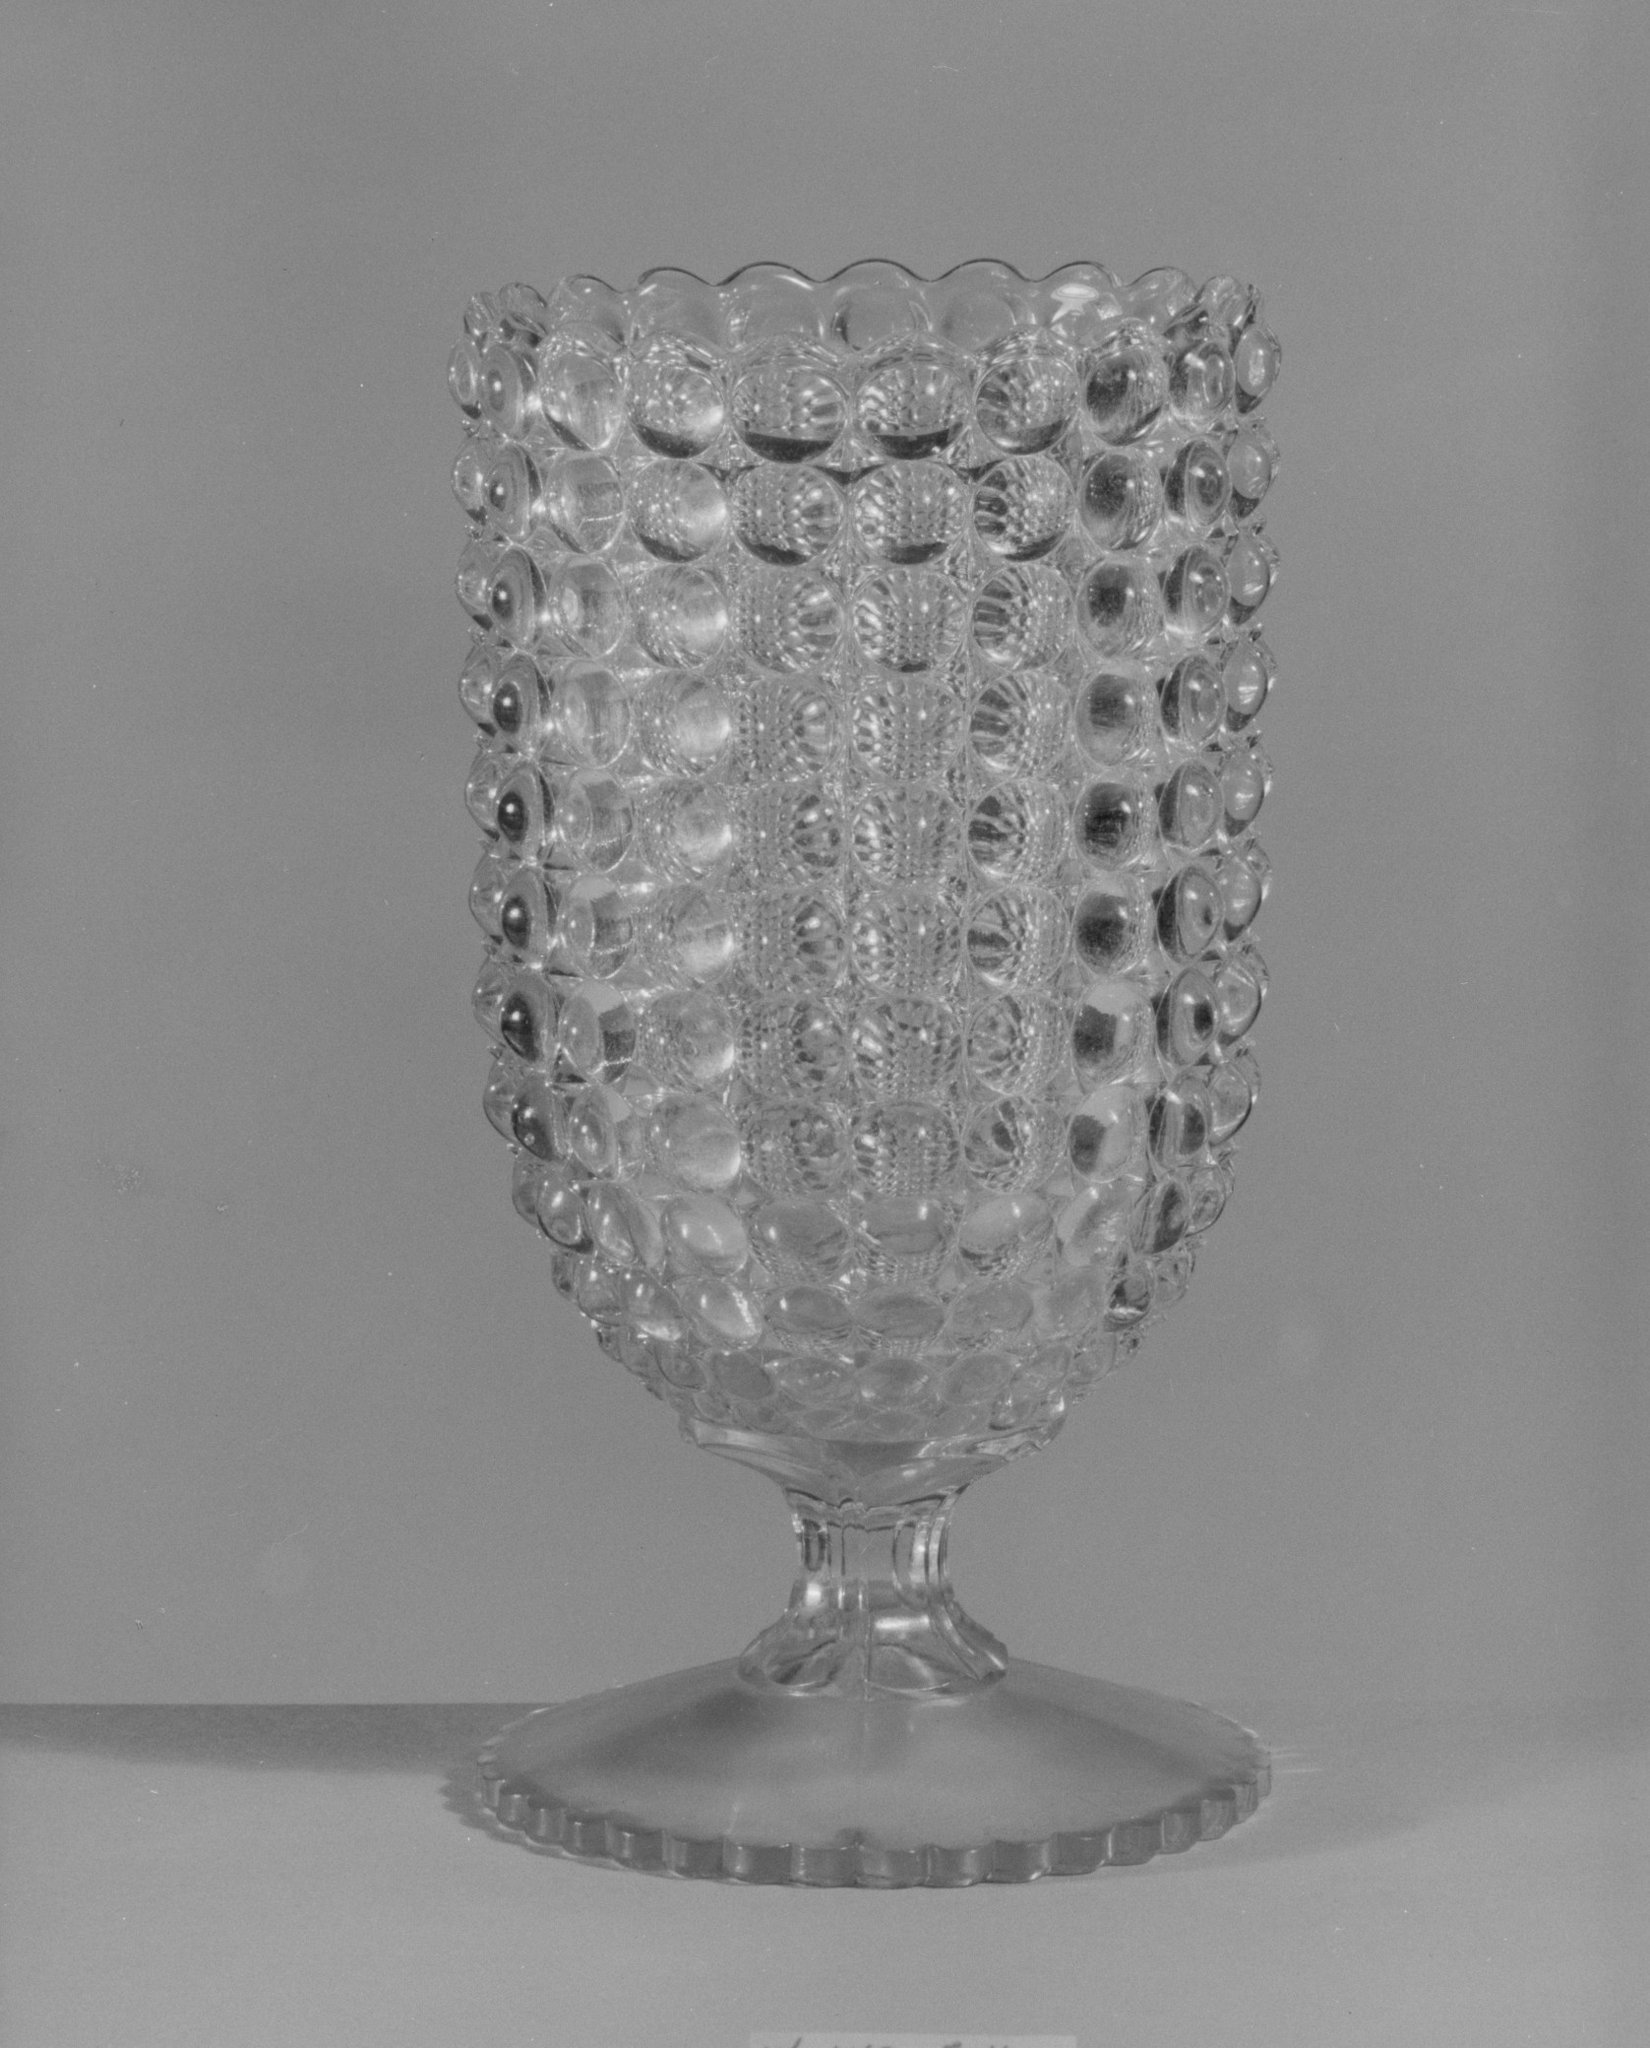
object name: celery vase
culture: american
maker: richards and hartley flint glass co.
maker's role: maker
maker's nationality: american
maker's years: 1867-1890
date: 1888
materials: glass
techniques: pressed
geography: united states